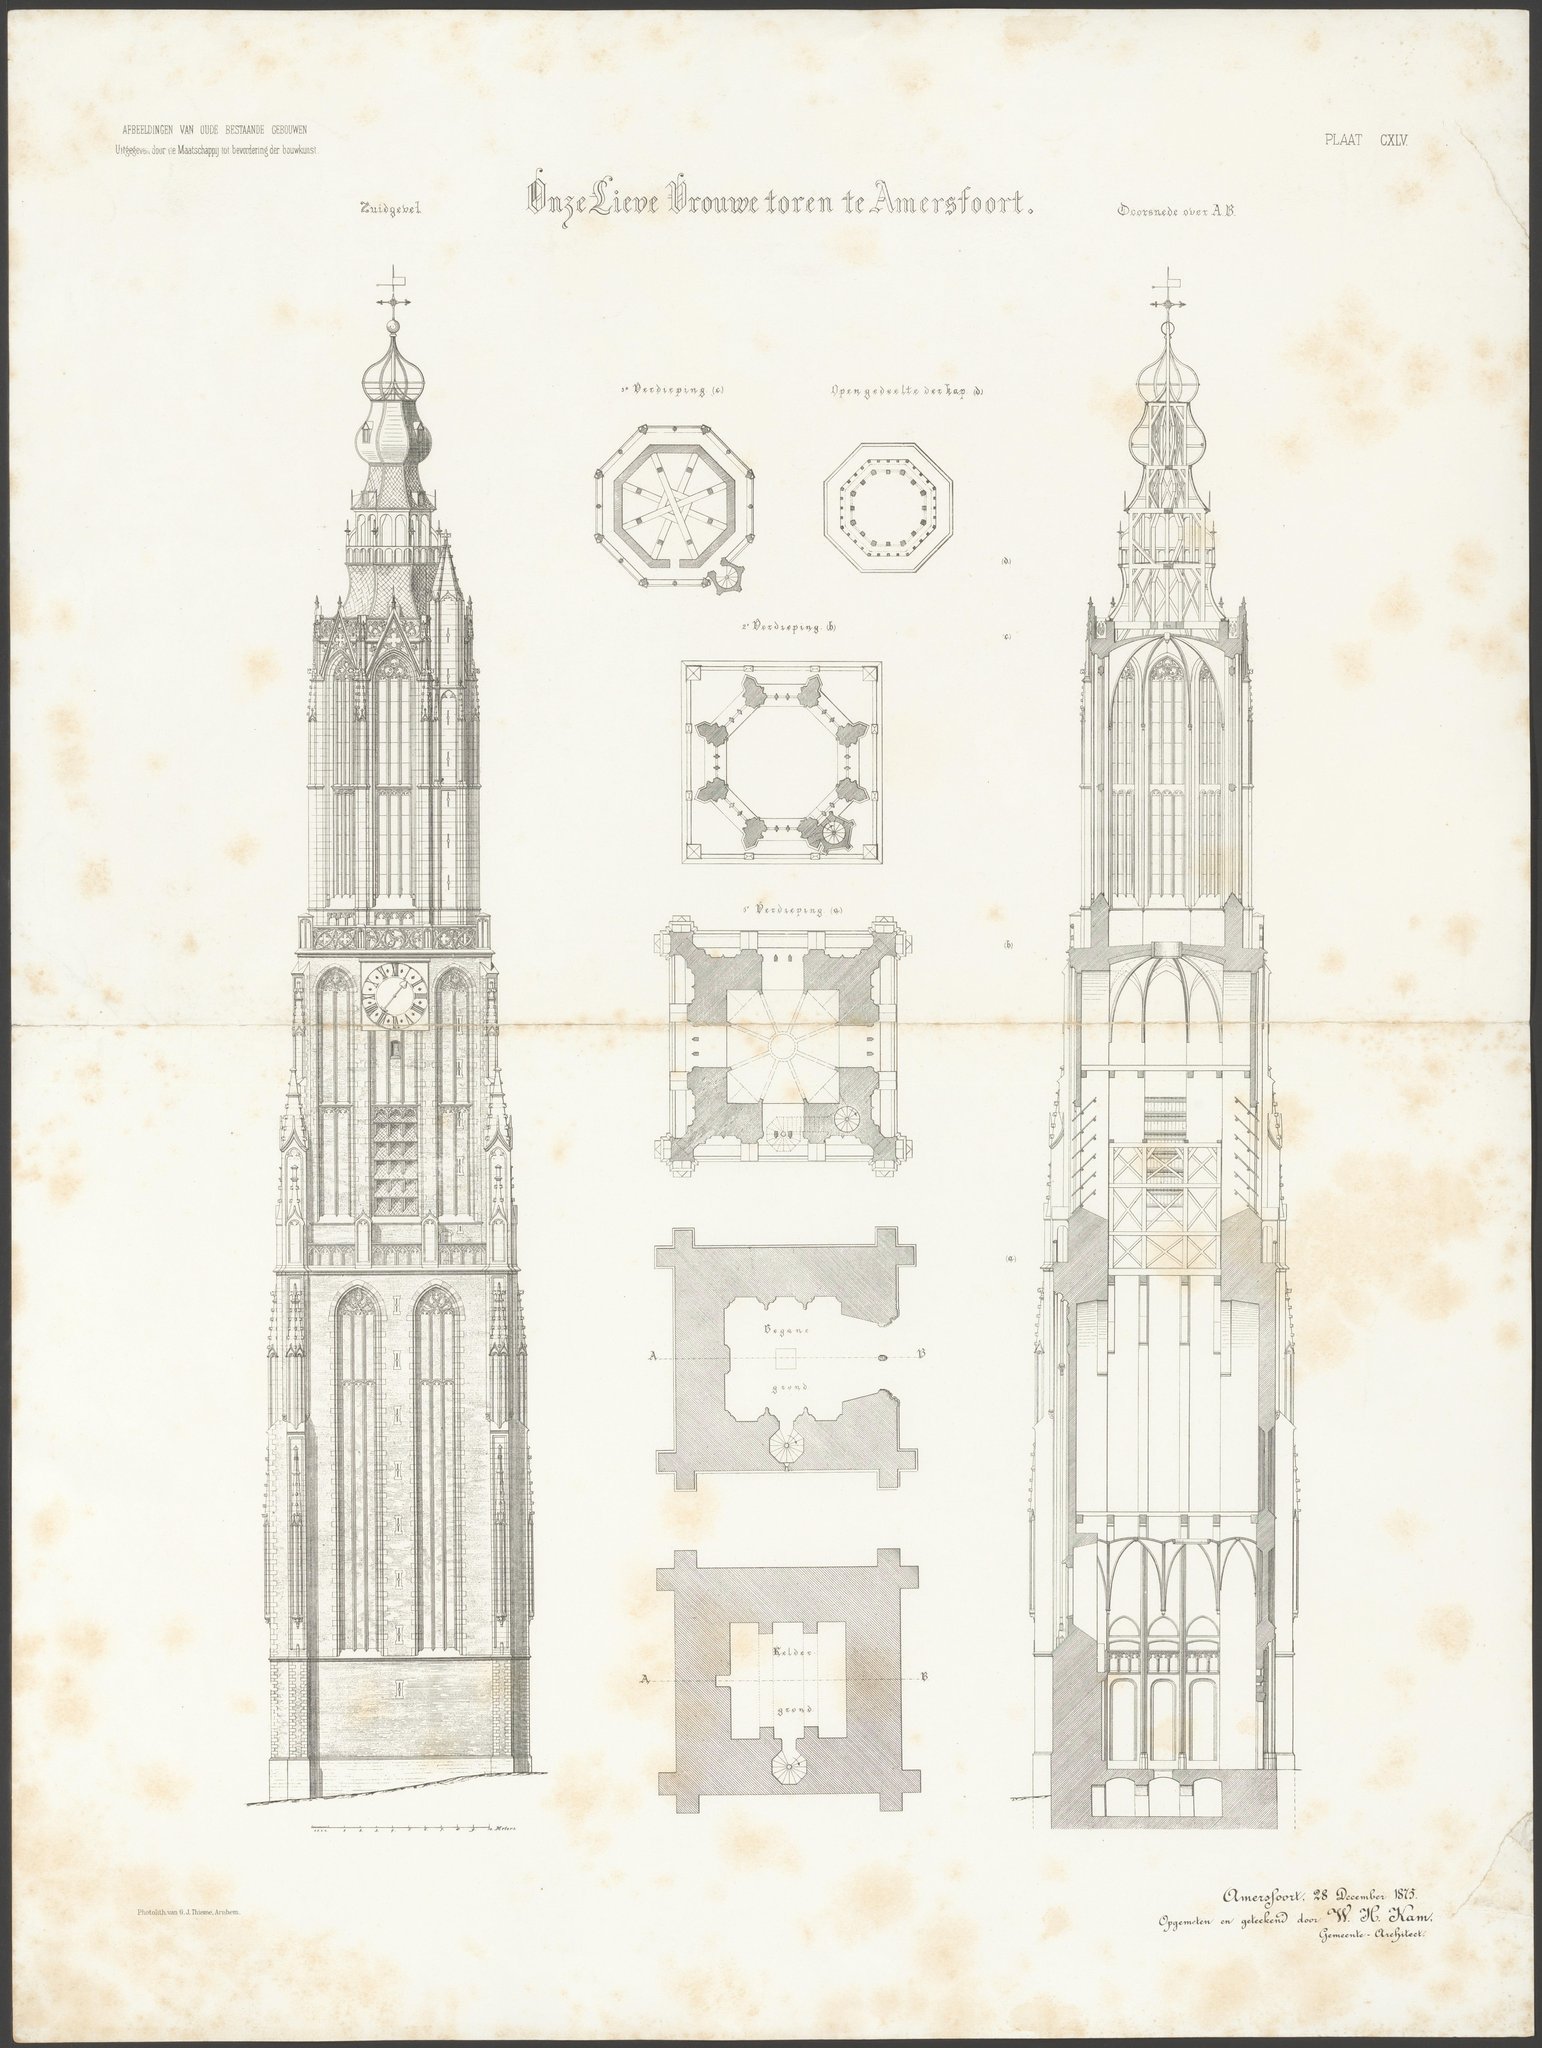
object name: photomechanical print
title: Onze-Lieve-Vrouwe toren te Amersfoort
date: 1887-1888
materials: paper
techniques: photolithography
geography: arnhem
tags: church (exterior), parts of church exterior and annexes: tower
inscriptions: collector's mark: Lugt 1641, collector's mark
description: Aanzicht, lengtedoorsnede en zes dwarsdoorsneden van de toren van de Onze-Lieve-Vrouwekerk te Amersfoort. Onderaan een schaalstok. Architectuurvoorstelling. Plaat CXLV. Onderwerpsrubrieken binnen de Atlas Zeden en Gewoonten: Kerk en kerkwezen & Armwezen en liefdadige instellingen; Kerkgebouwen elders. A-E.